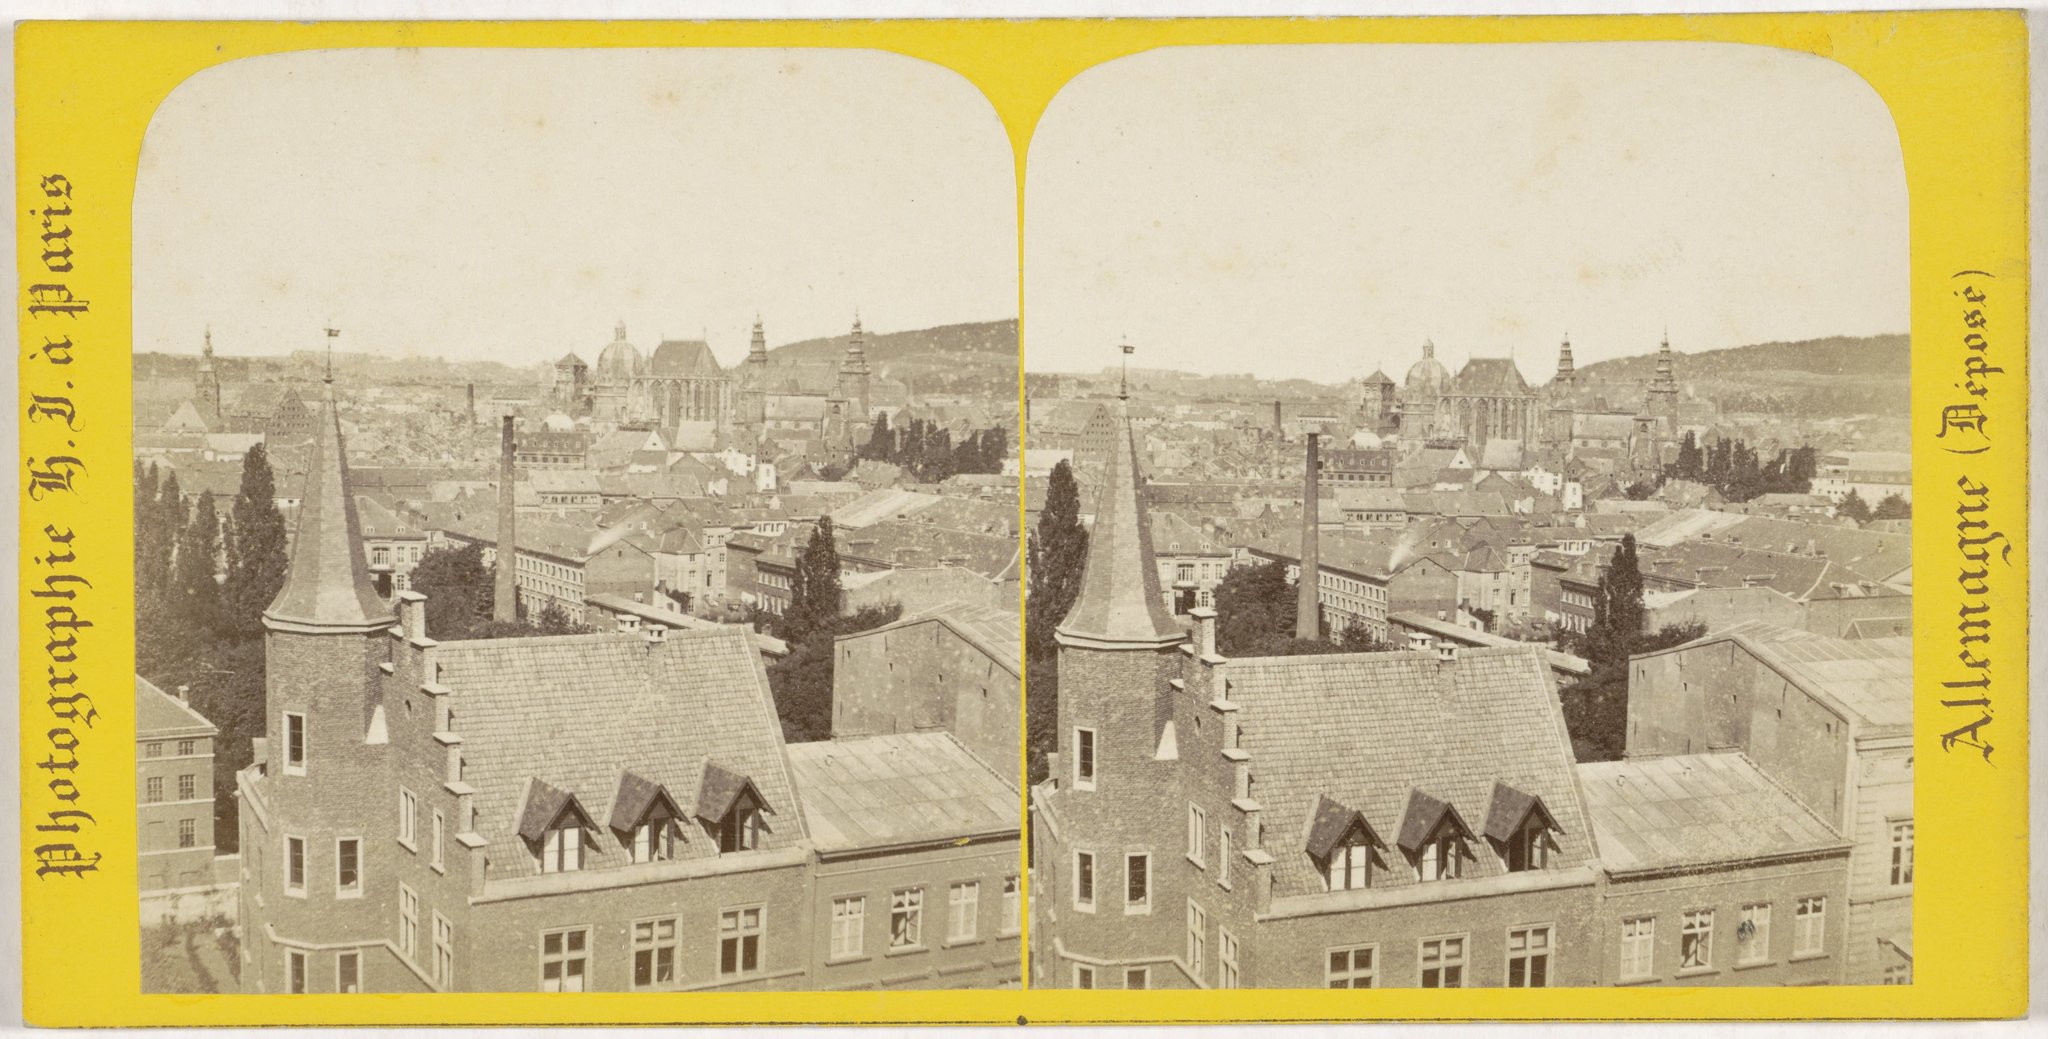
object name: stereograph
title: Panorama sur la Cathédrale et l'Hôtel-de-Ville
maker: hippolyte jouvin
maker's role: fotograaf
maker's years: 1825-1889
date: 1864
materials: cardboard, paper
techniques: albumen print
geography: aachen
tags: city-view in general; 'veduta', church (exterior), townhall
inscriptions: inscription: ‘(Déposé)’, inscription: ‘Déposé.’, number: ‘N. 560’